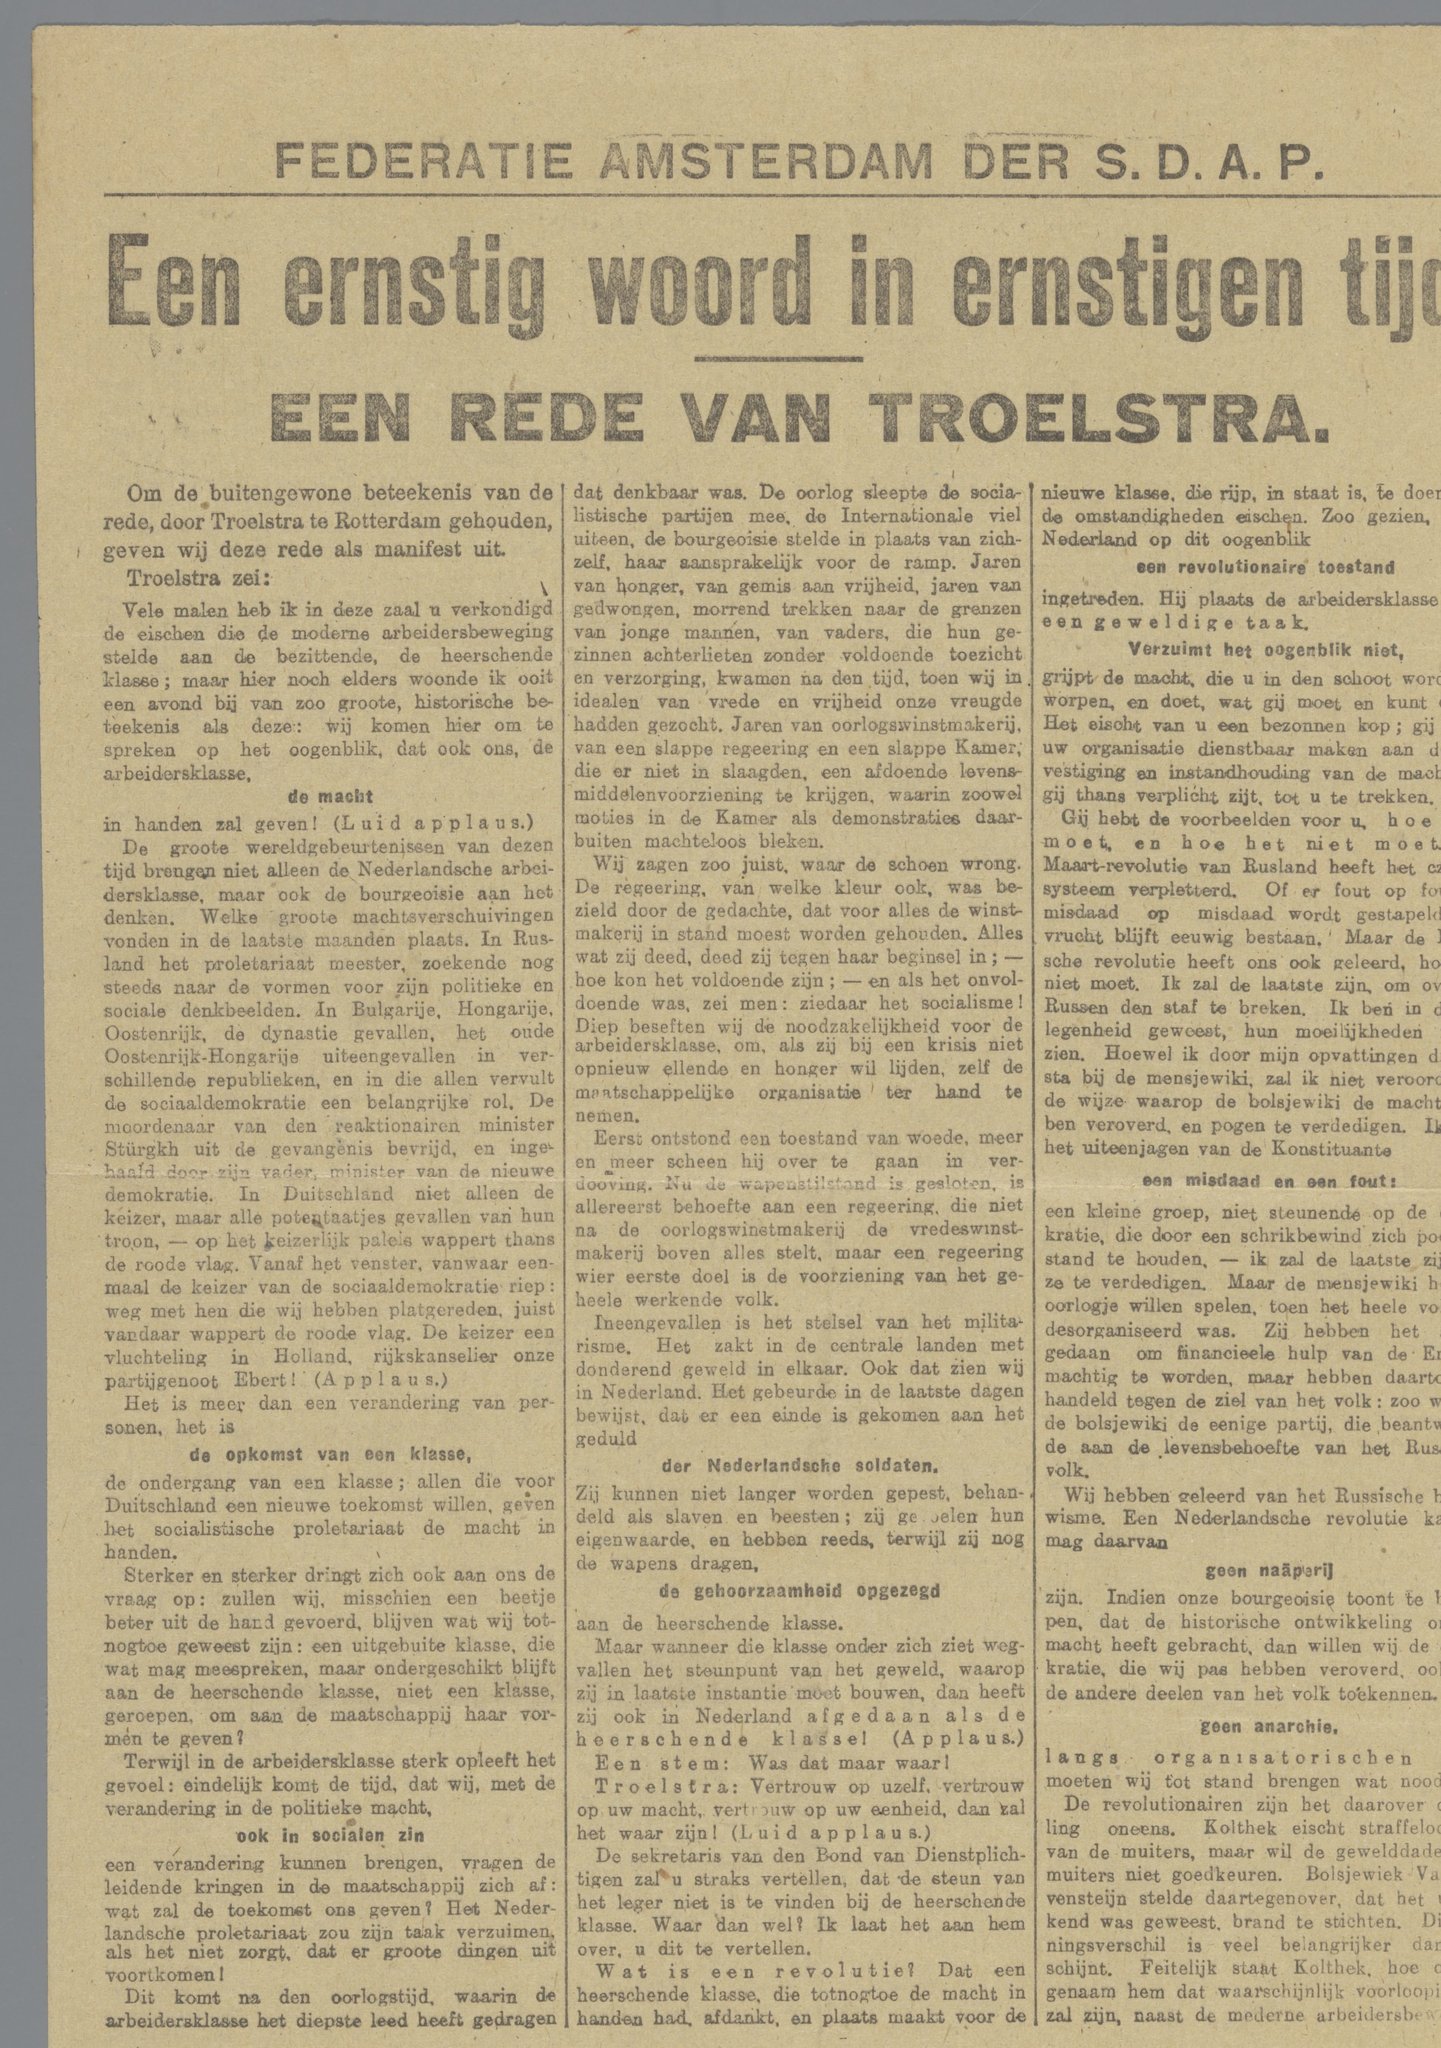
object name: pamphlet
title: Een ernstig woord in ernstigen tijd; een rede van Troelstra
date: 1918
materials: paper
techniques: printing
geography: amsterdam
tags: netherlands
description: Tweezijdig bedrukt vel papier in drie kolommen. Opschrift; b.: 'Federatie Amsterdam der S.D.A.P.'.